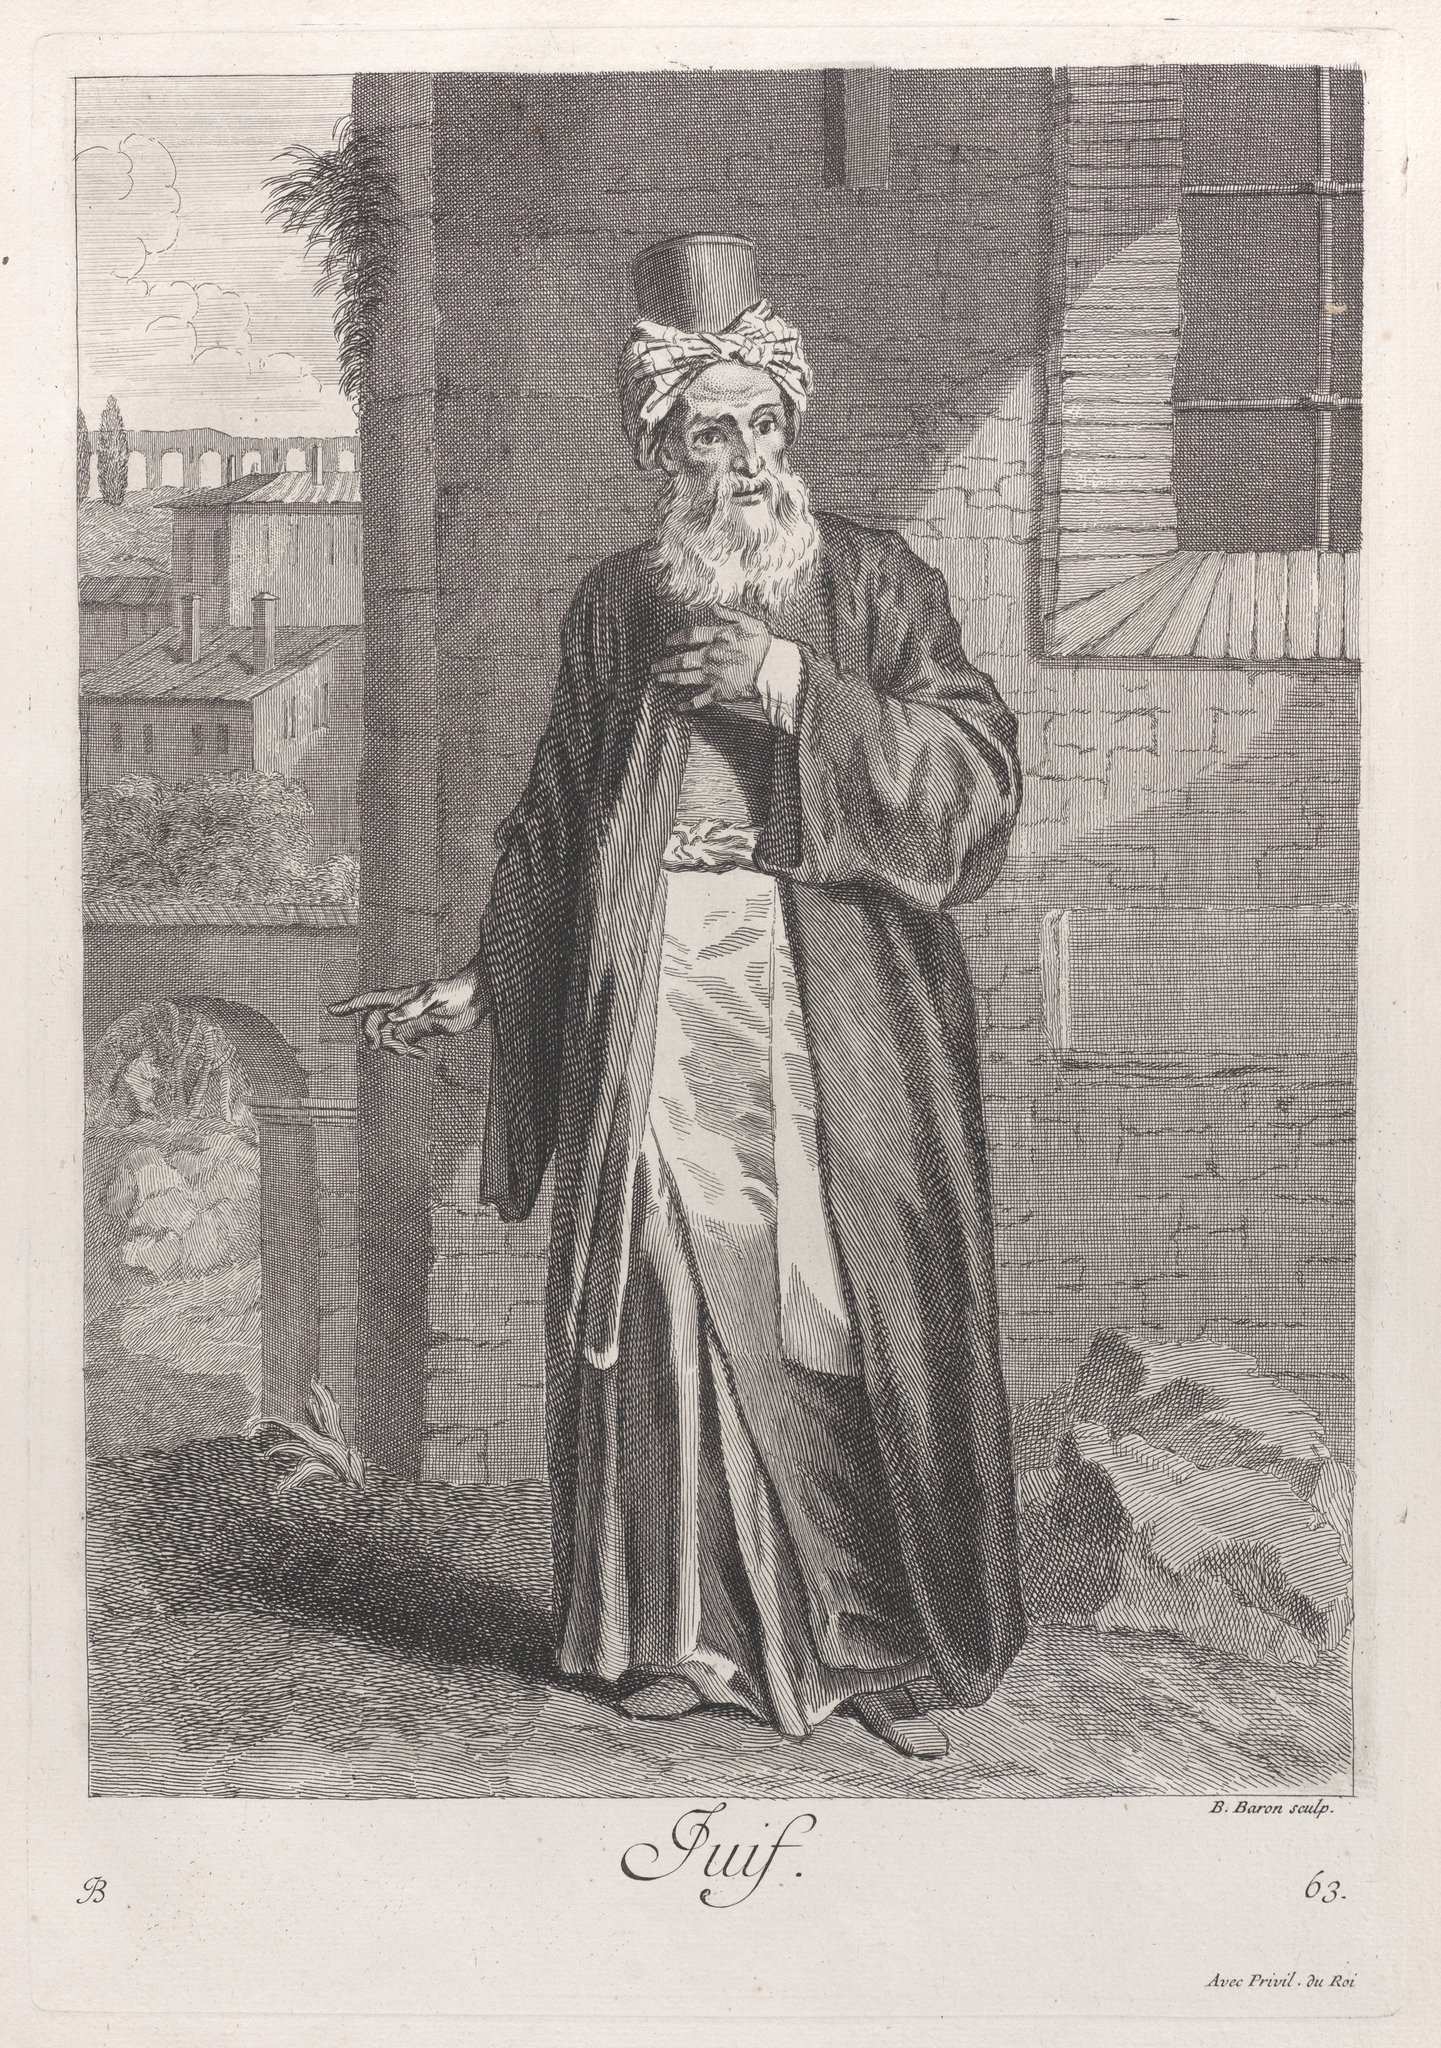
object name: print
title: Juif, plate 63 from "Recueil de cent estampes représentent differentes nations du Levant"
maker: jean baptiste vanmour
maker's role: artist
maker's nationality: french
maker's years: 1671-1737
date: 1714-1715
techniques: engraving, etching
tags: men